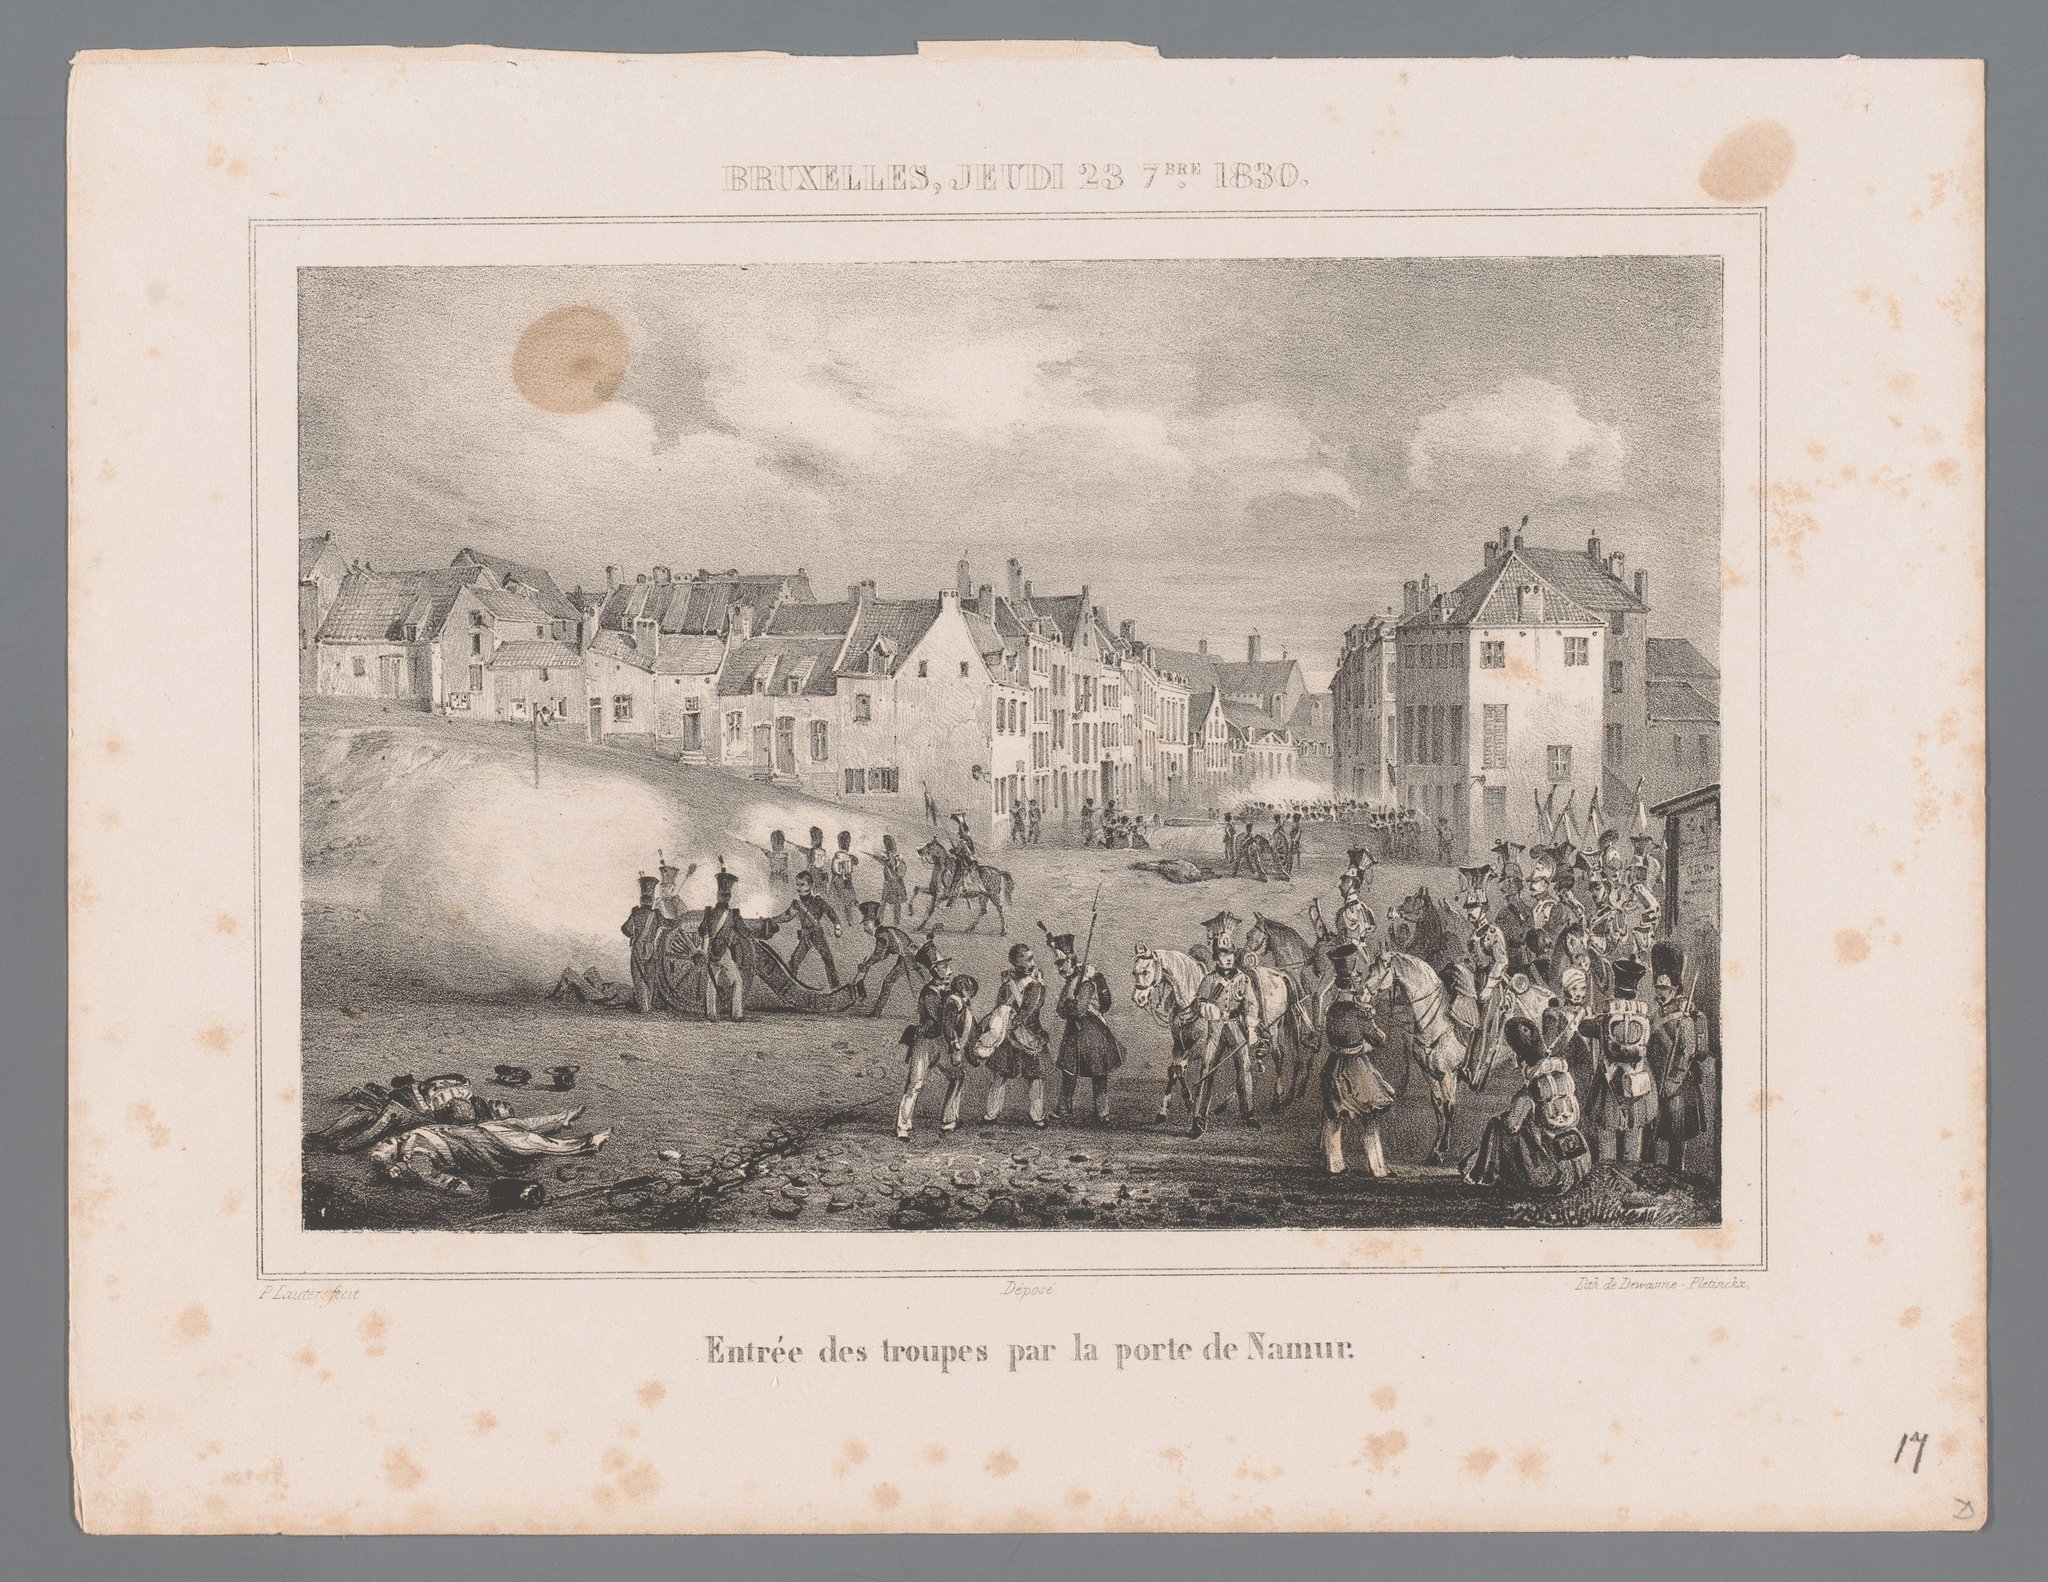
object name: print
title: Gebeurtenissen in Brussel, Antwerpen (...)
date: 1830-1831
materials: paper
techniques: lithograph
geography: brussels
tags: barricades ~ riot, battle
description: Prent maakt deel uit van een serie met prenten over de gebeurtenissen tijdens de Belgische Revolutie in Brussel, Antwerpen en andere steden in de periode 25 augustus 1830 tot 27 maart 1831.